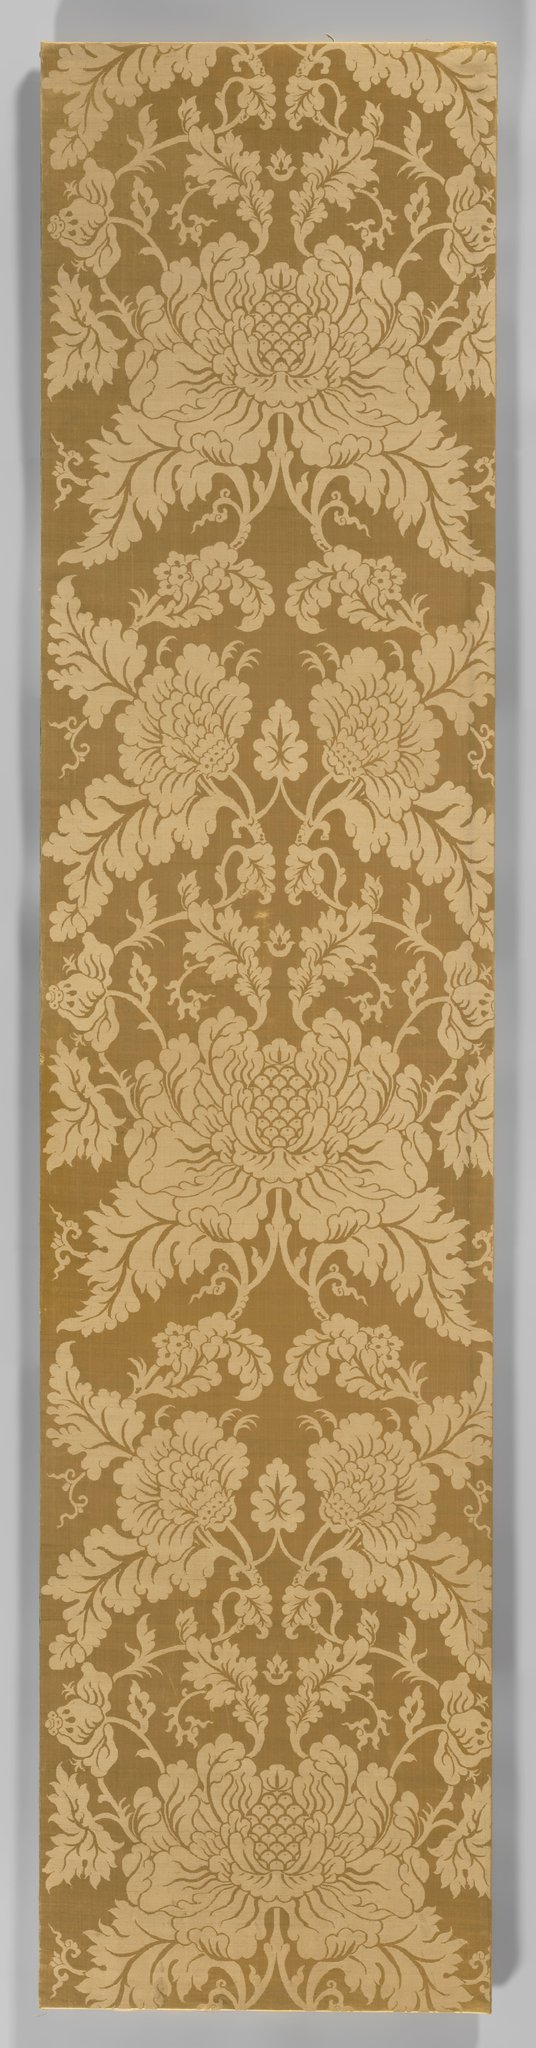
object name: silk textile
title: Wandbespanning van geel zijden damasten met symmetrisch patroon van twee opgaande golvende ranken met onder andere pioenvormige bloemen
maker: Anonymous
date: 1700-1725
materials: silk, wood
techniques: damask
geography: france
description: Geel zijden damasten wandbespanning. Symmetrisch patroon van twee opgaande golvende ranken waaraan grote pioenvormige bloemen met geschubtd hart; kleinere bloemen zijn paarsgewijs geplaatst, evenals bloemknoppen, gevederde bladeren en arabeskrankjes, die eindigen in wolkenbanden. Patroon van keperstreep, fond van satijnbinding. Afkomstig uit het pand Voorstraat 140 te Dordrecht. Eén baan heeft aan de onderkant wat waterschade.